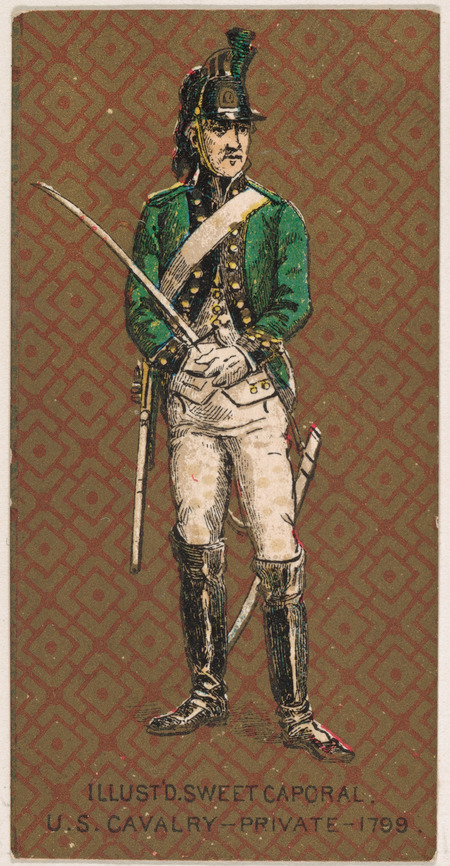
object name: print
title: Private, Cavalry, United States Army, 1799, from the Military Series (N224) issued by Kinney Tobacco Company to promote Sweet Caporal Cigarettes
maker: kinney brothers tobacco company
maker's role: publisher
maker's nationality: american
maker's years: 1869-2011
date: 1888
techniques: color lithograph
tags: military,men